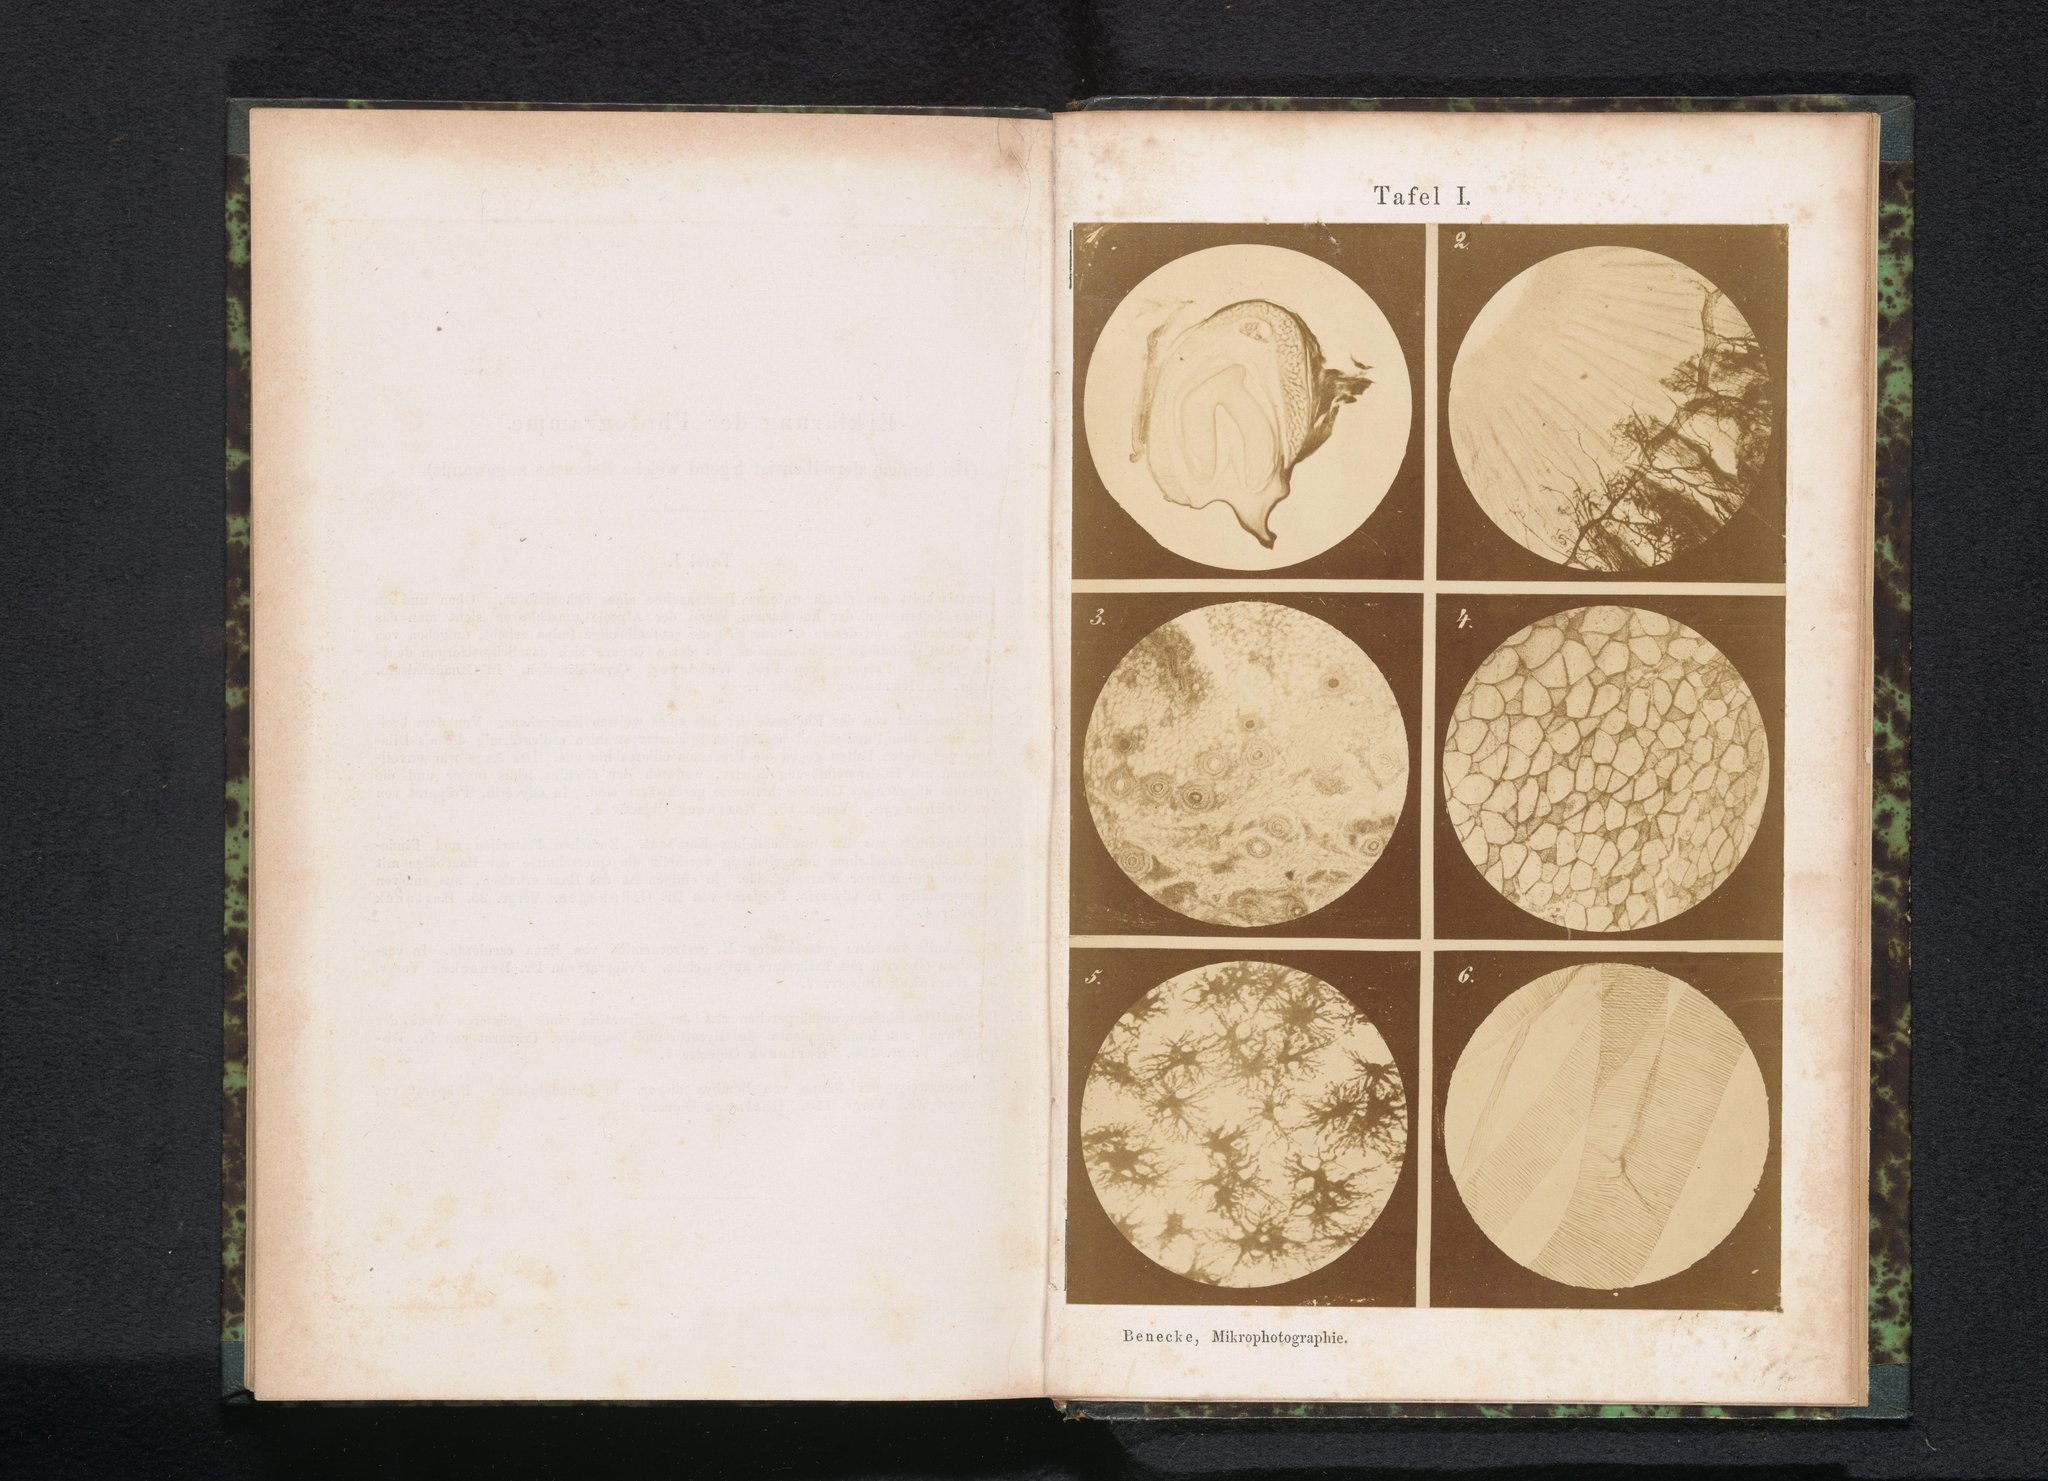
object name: page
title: Zes microscopische vergrotingen van onderdelen van het menselijk lichaam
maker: berthold benecke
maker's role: anatoom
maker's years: 1843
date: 1858-1868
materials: photographic support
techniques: albumen print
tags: blood circulation, muscles, other anatomical details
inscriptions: number: ‘1. (...) 6.’, number: ‘Tafel I.’